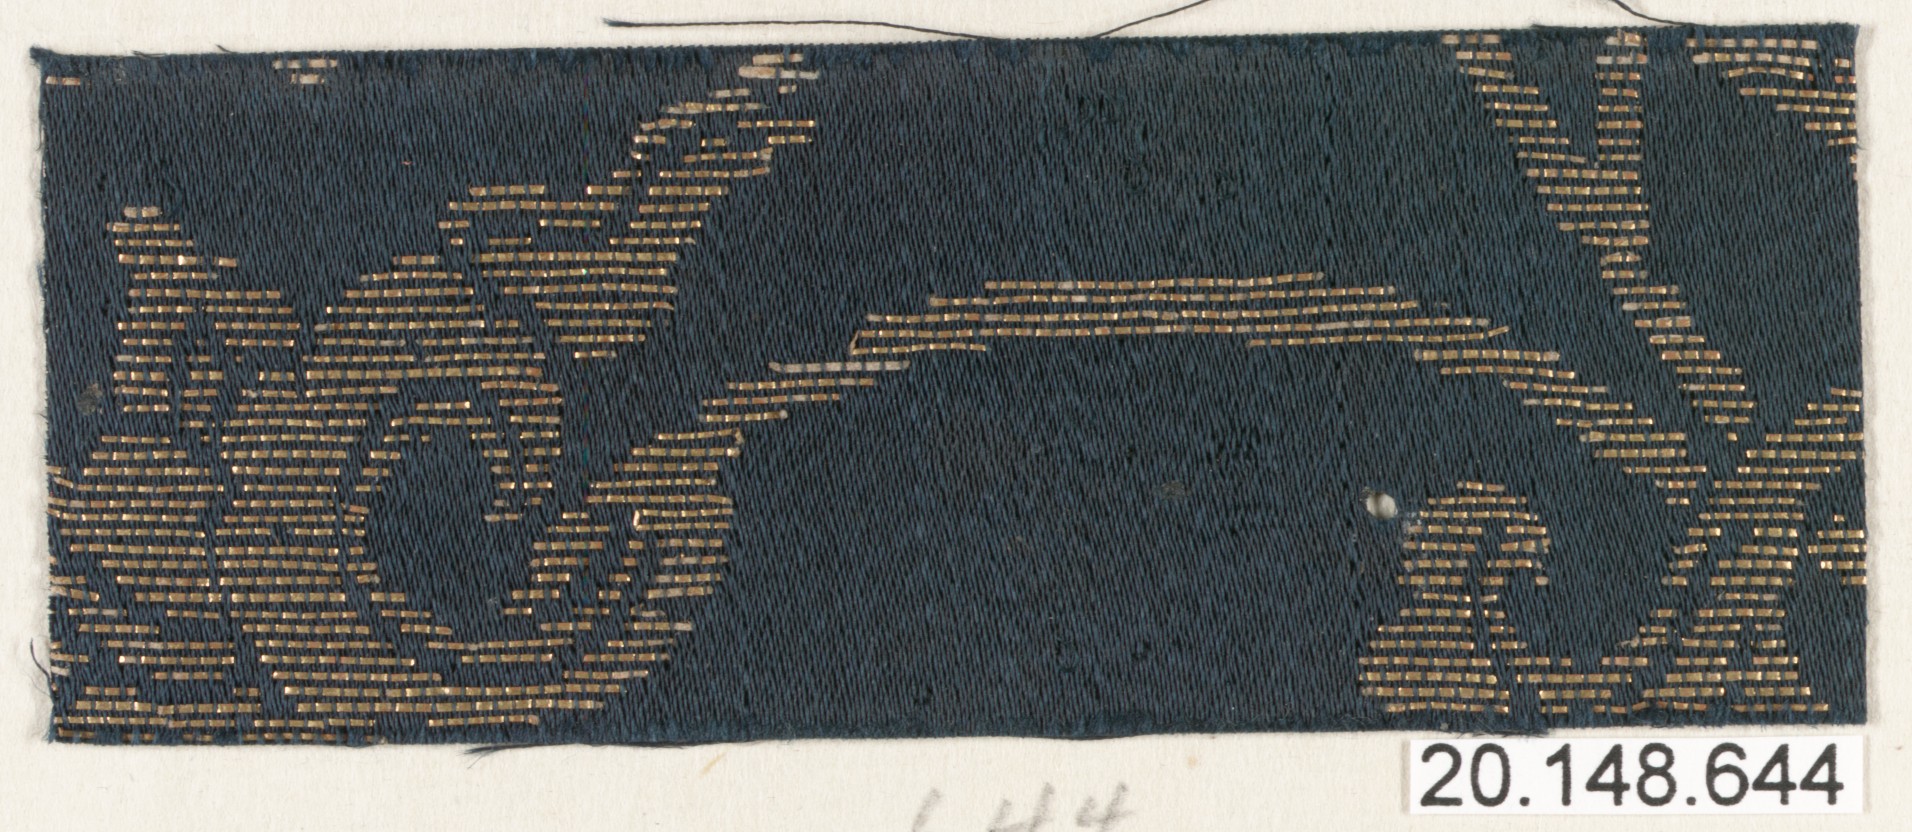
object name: piece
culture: japanese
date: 1701-1800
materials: silk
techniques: compound weave